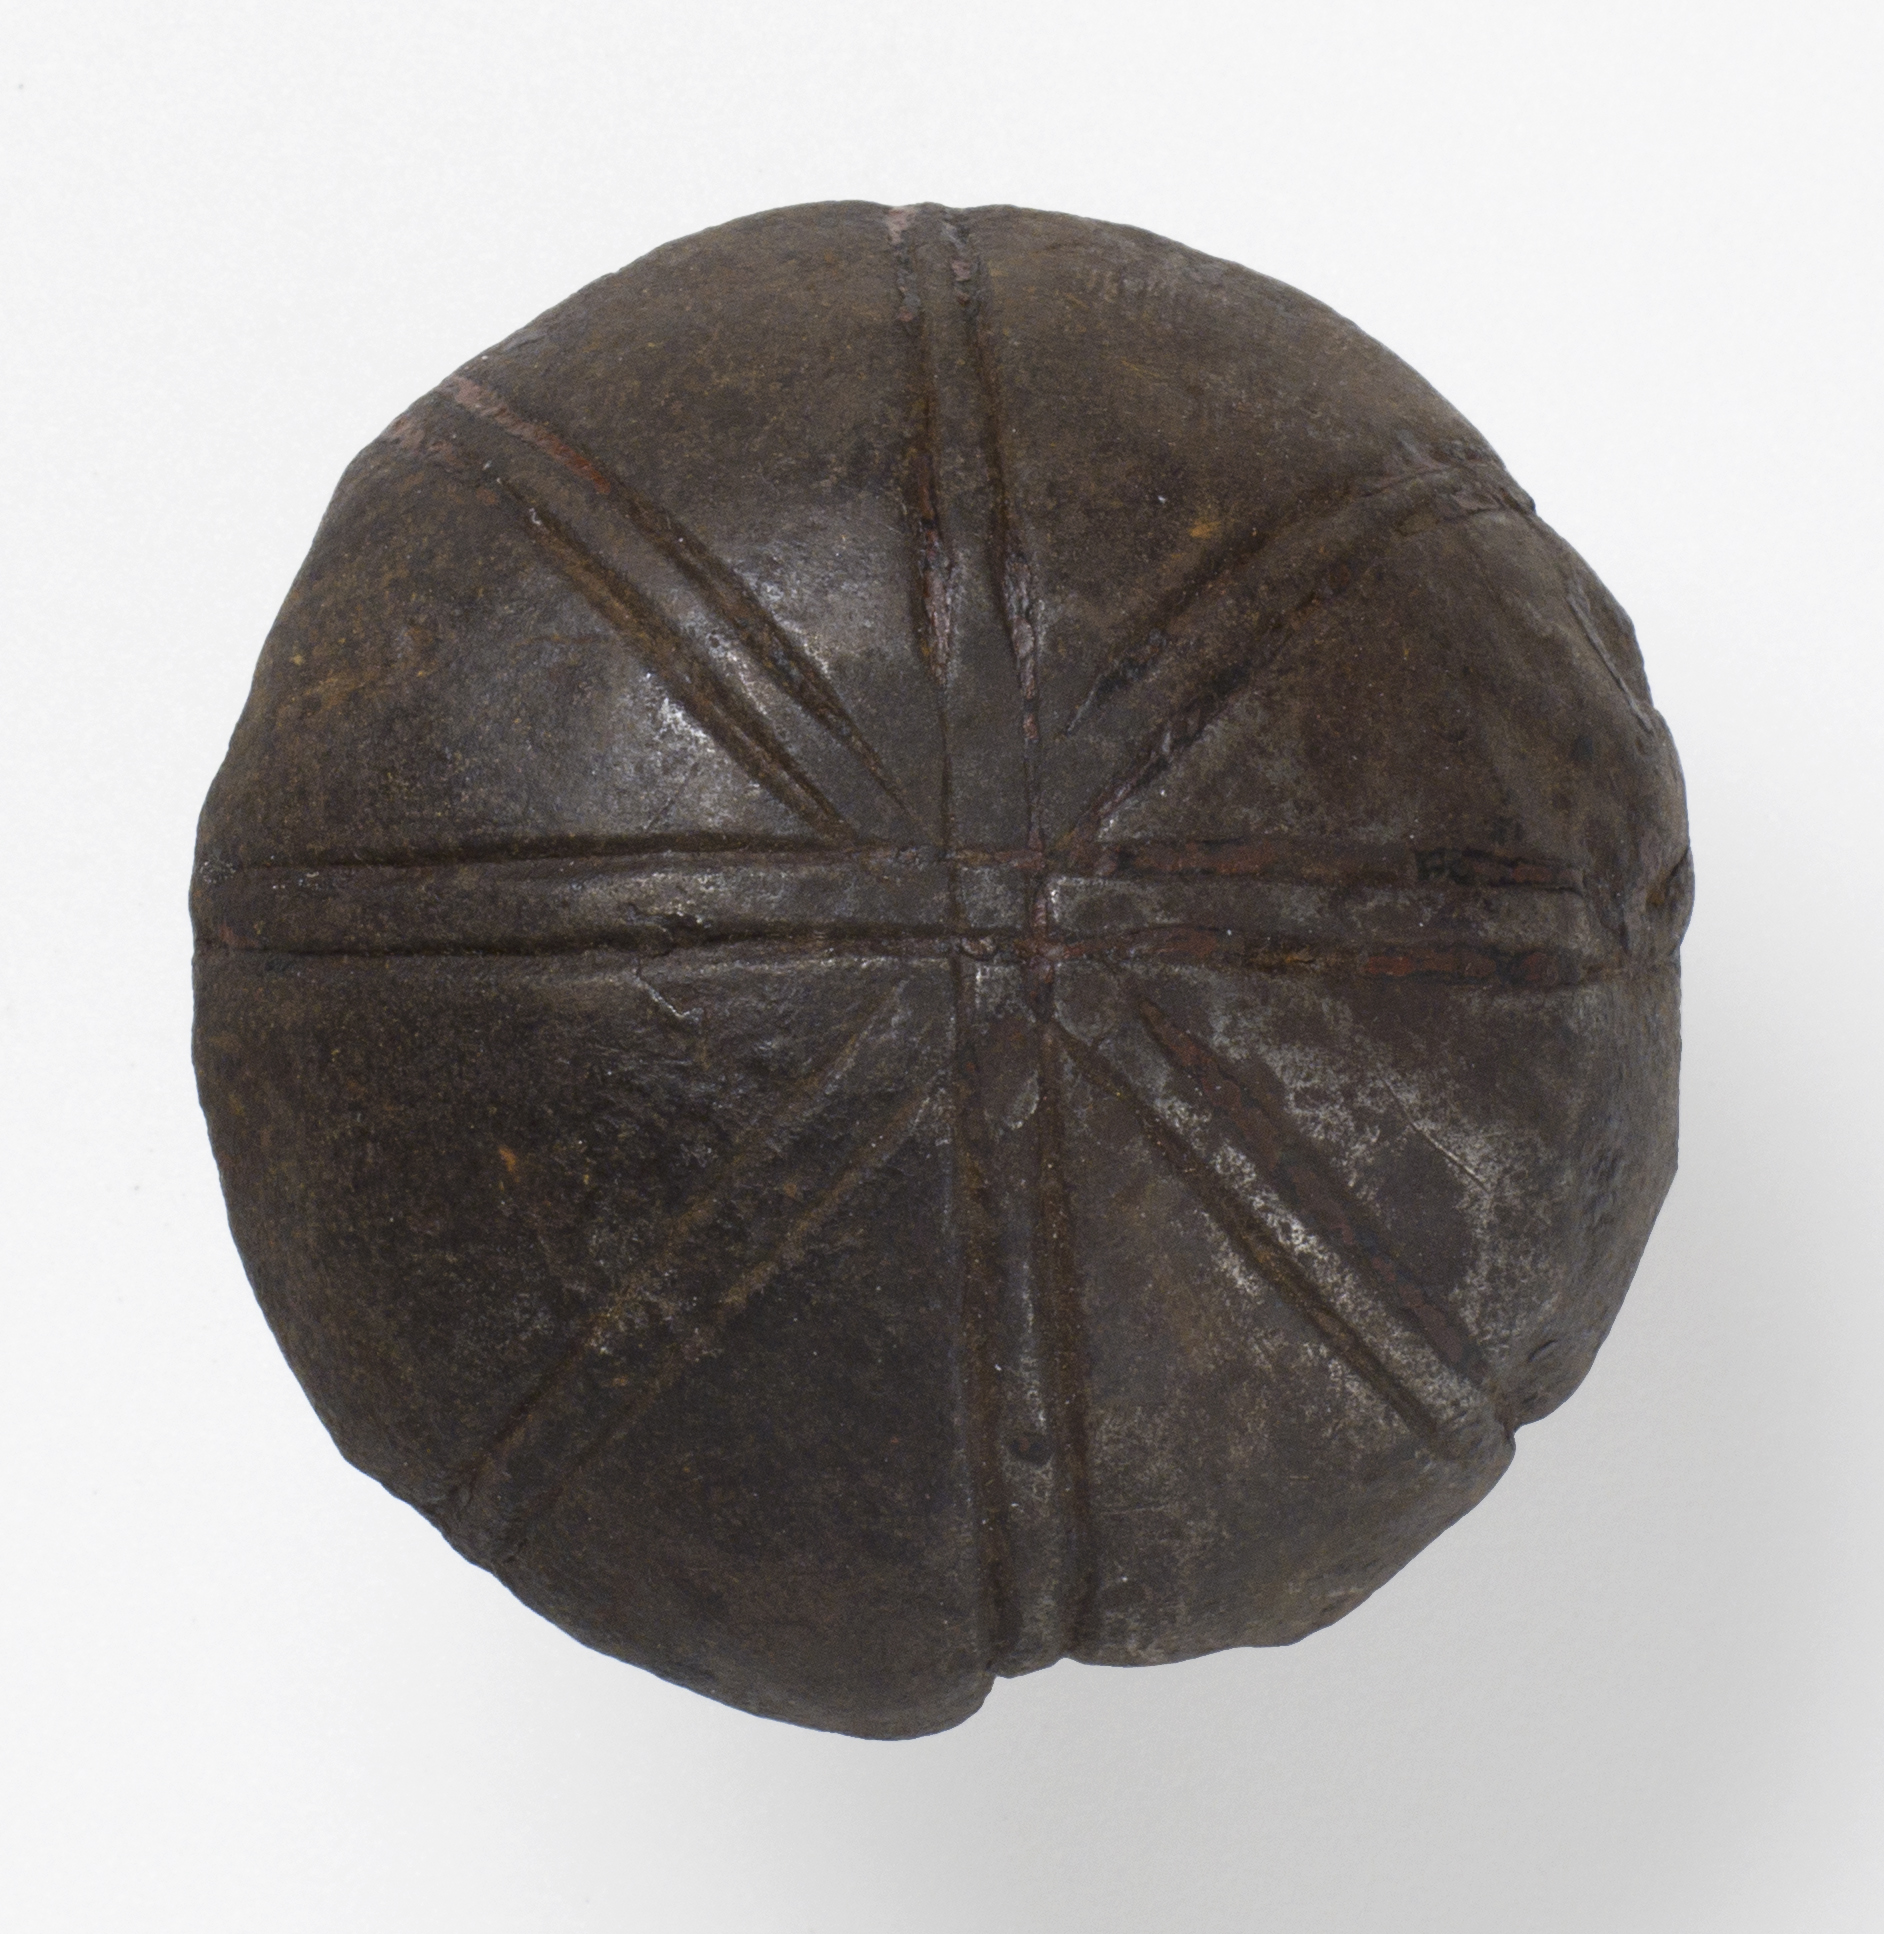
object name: nail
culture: european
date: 1401-1600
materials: iron